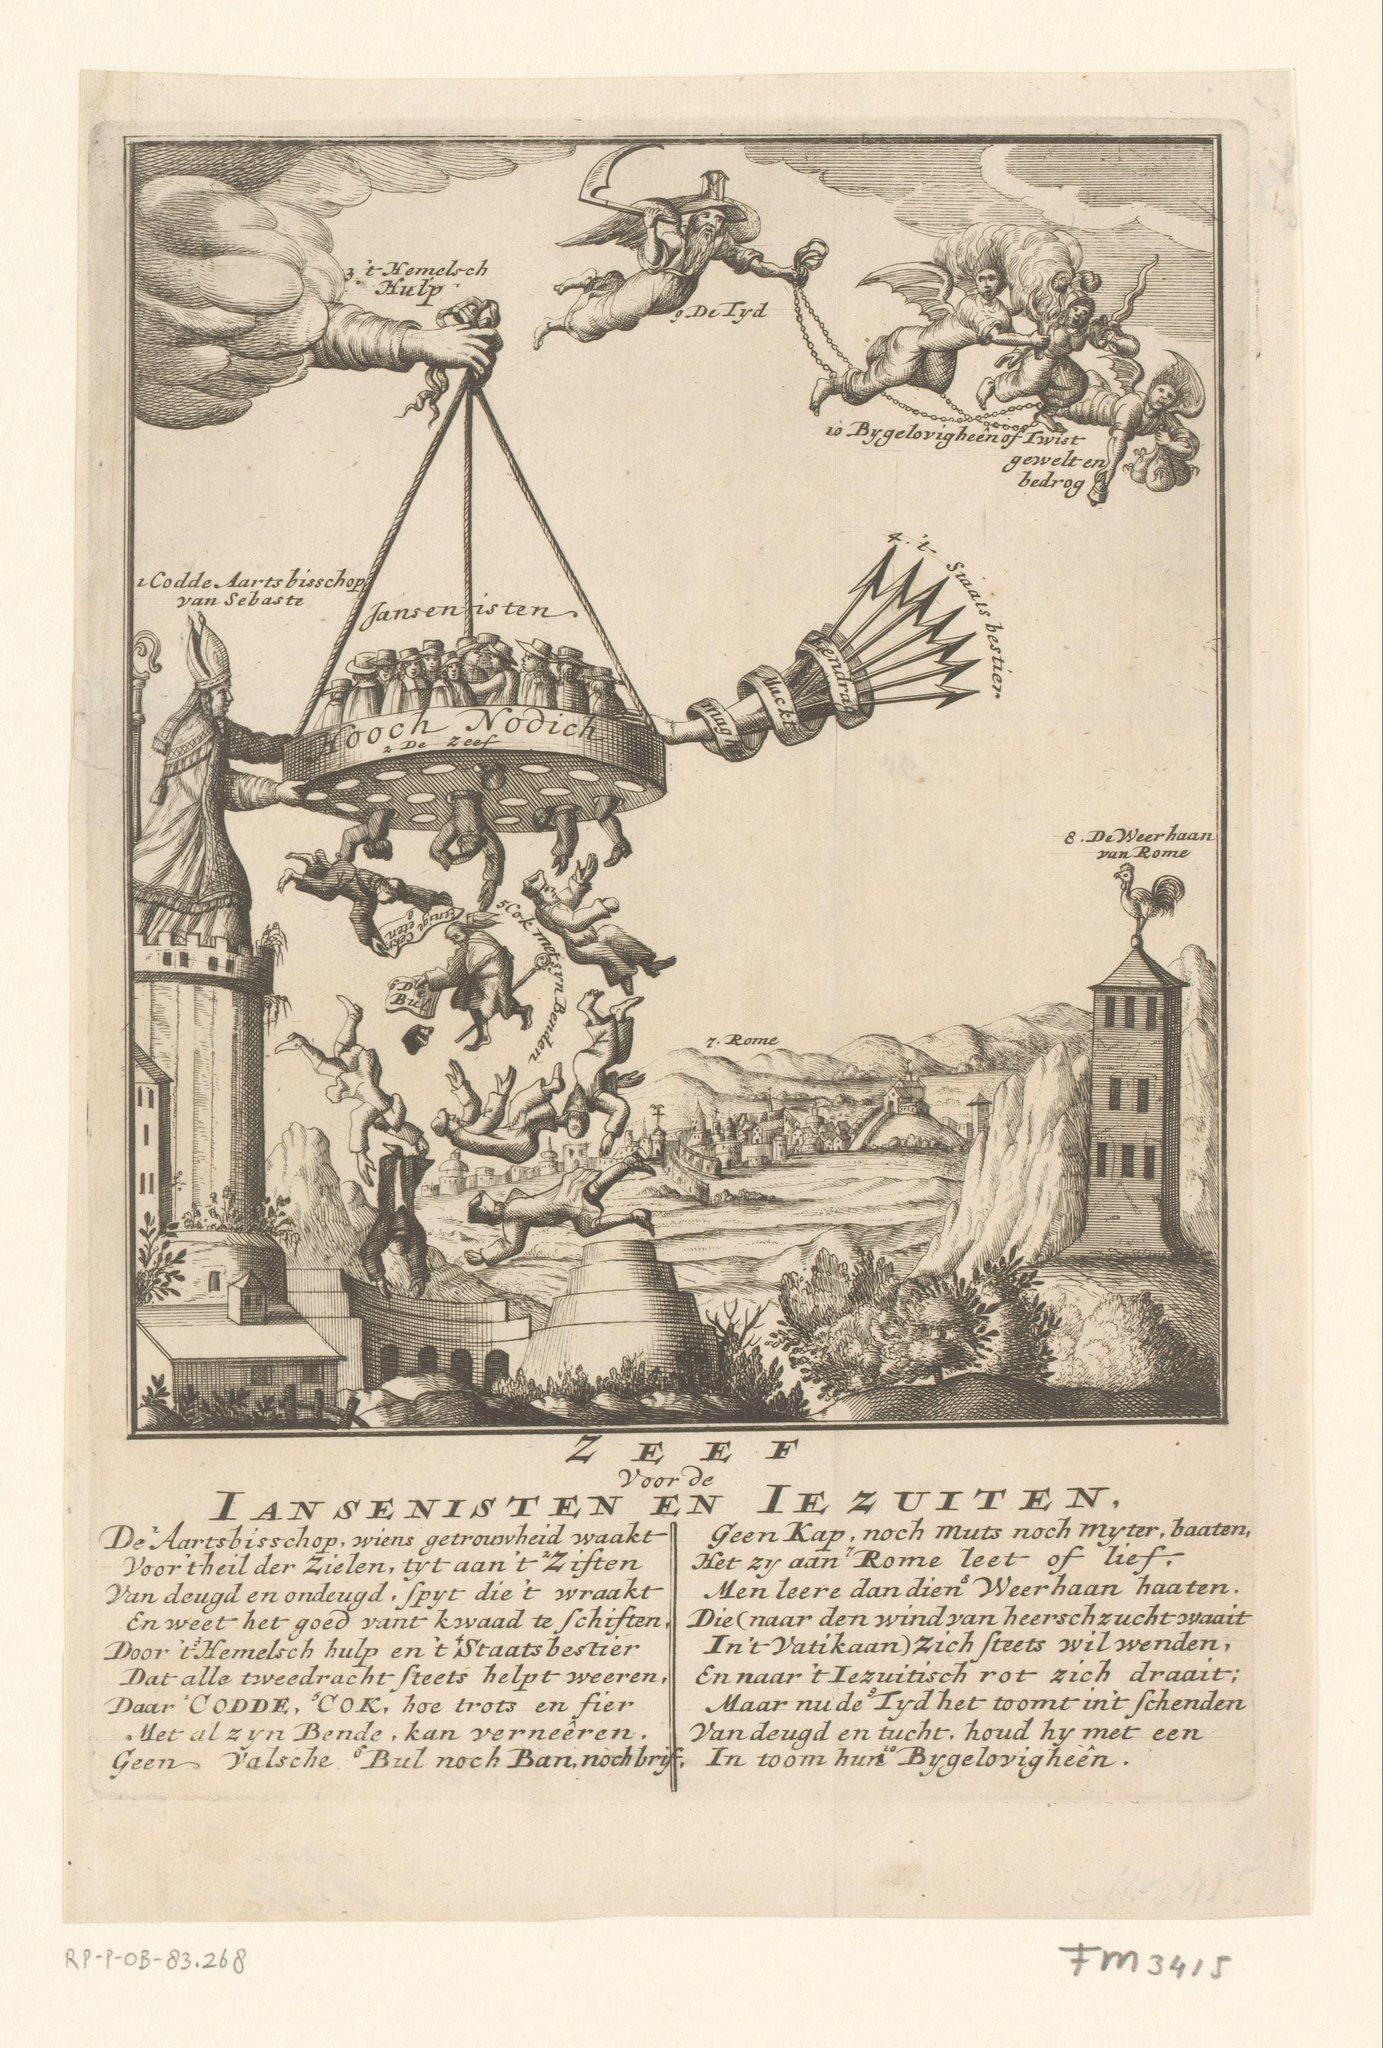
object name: cartoon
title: Jansenisten en monniken zeef, 1705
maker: Anonymous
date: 1705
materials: paper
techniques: etching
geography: northern netherlands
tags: utrecht, rome, sorting, selecting of material by sieving, sifting, screening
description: Petrus Codde schudt met hulp van de hand van de Republiek aan een grote zeef vastgehouden door de hand van God waar de jezuïeten doorheen vallen en waarin jansenisten overblijven, 1705. In het onderschrift een vers in twee kolommen.